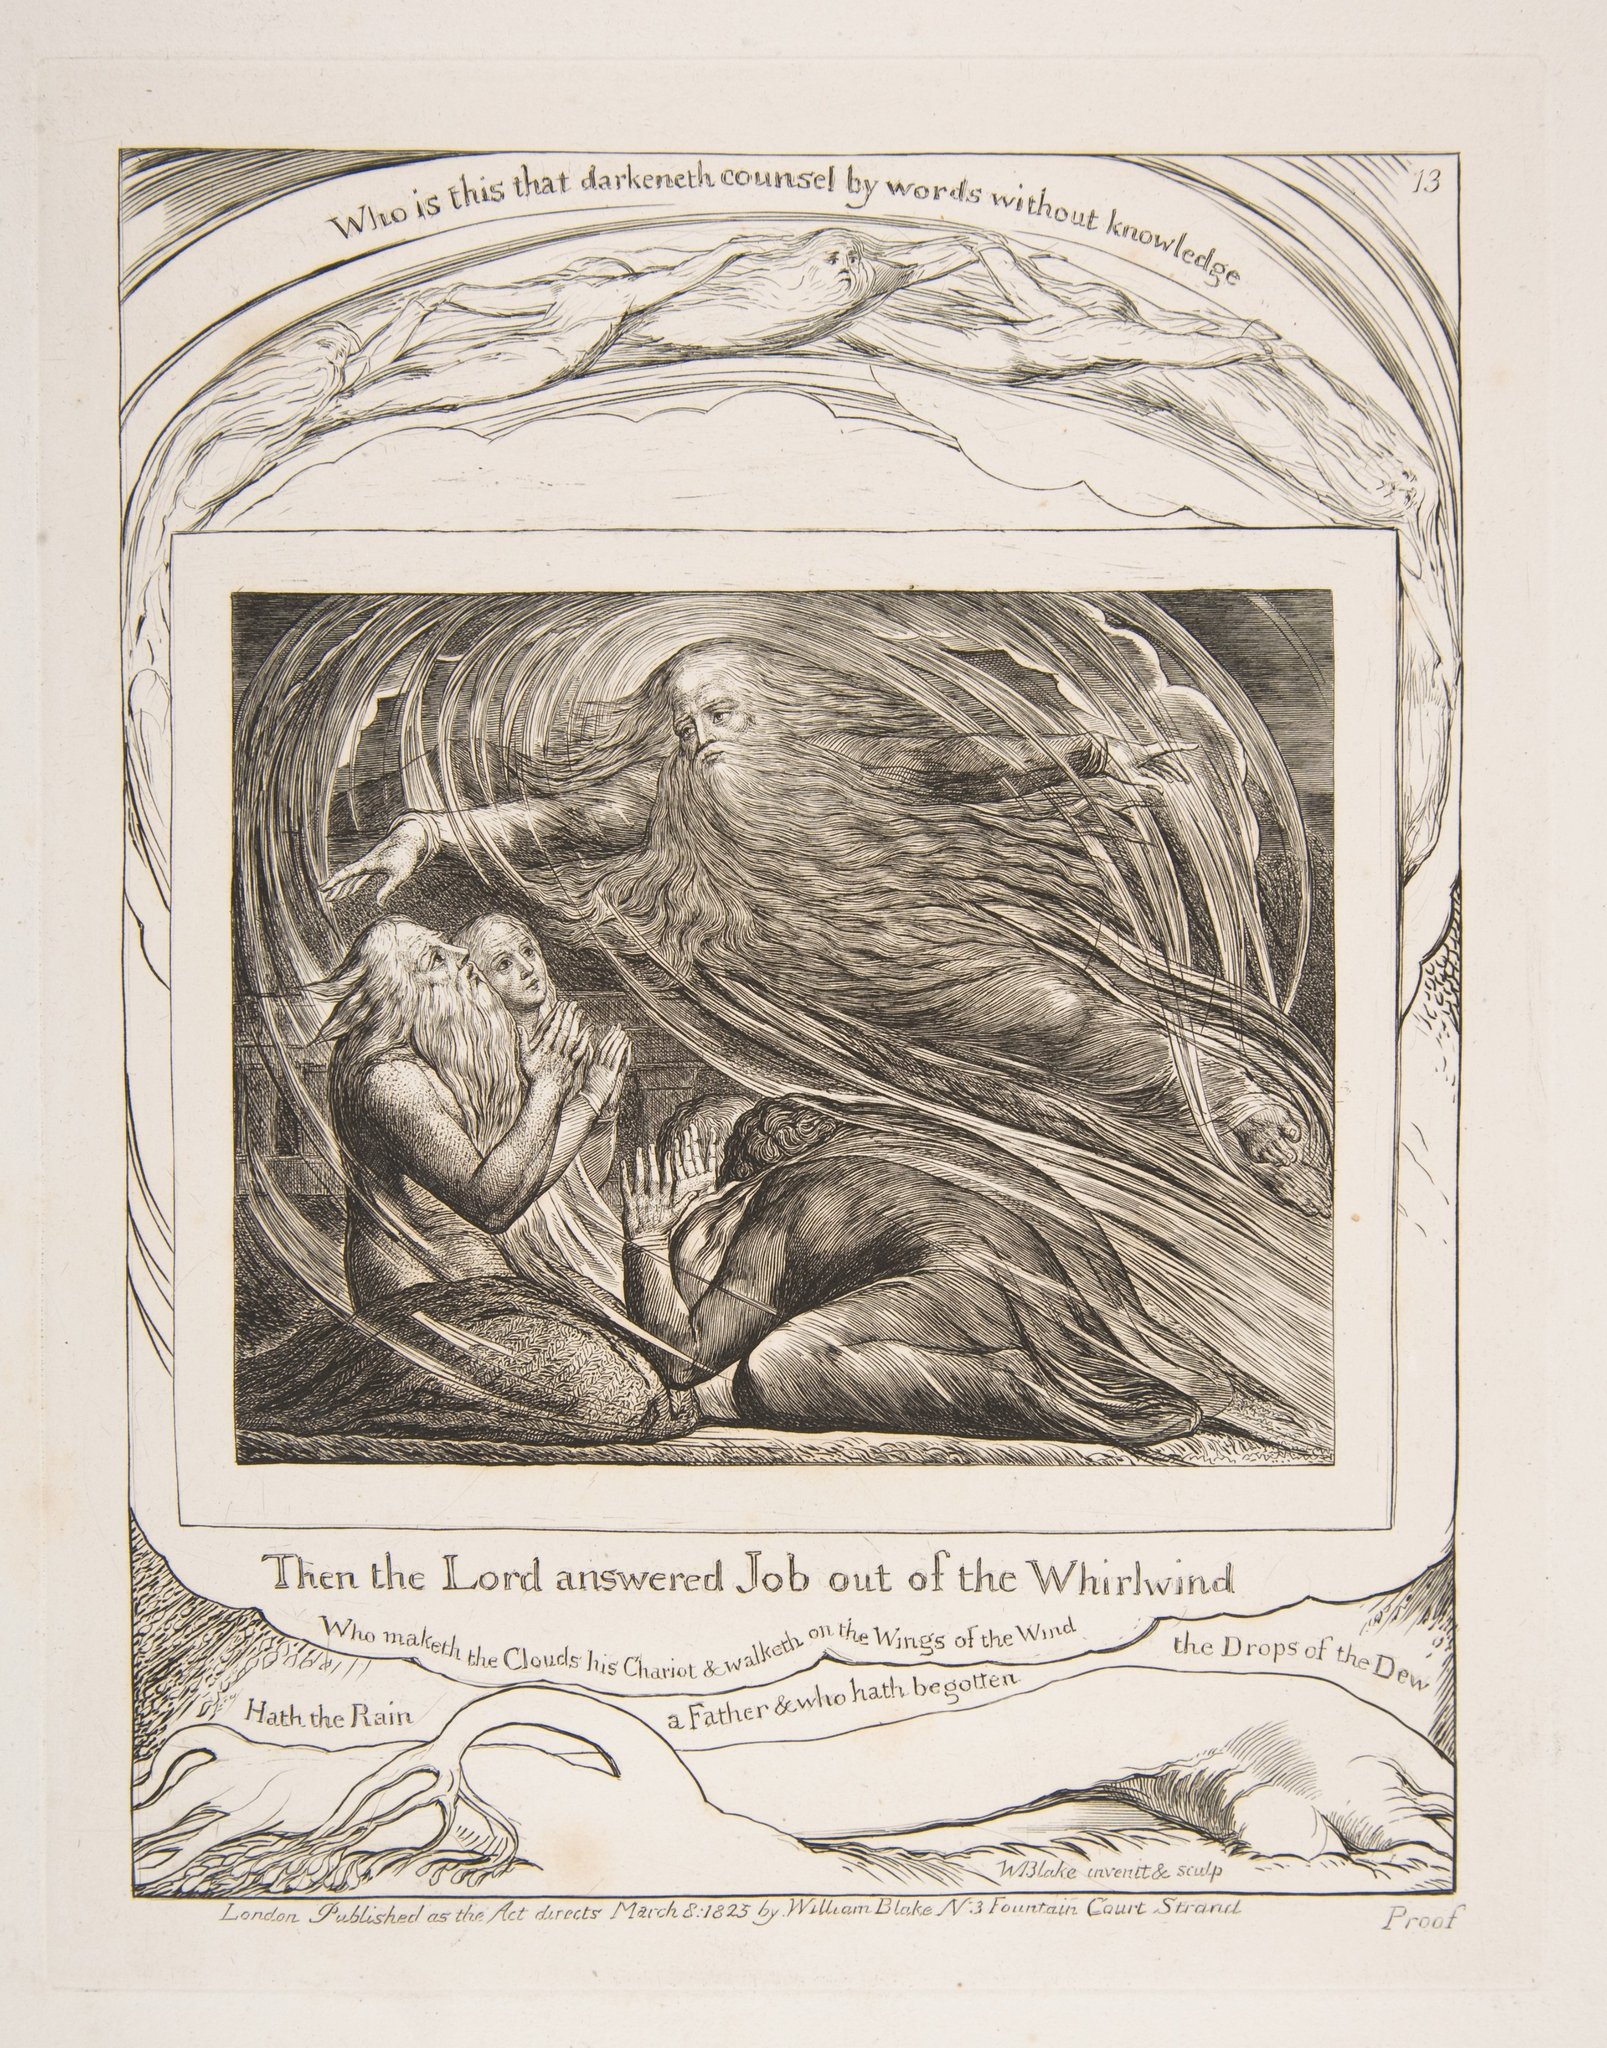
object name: print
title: The Lord Answering Job out of the Whirlwind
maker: william blake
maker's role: artist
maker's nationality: british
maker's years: 1757-1827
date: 1825-1826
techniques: engraving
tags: men,job